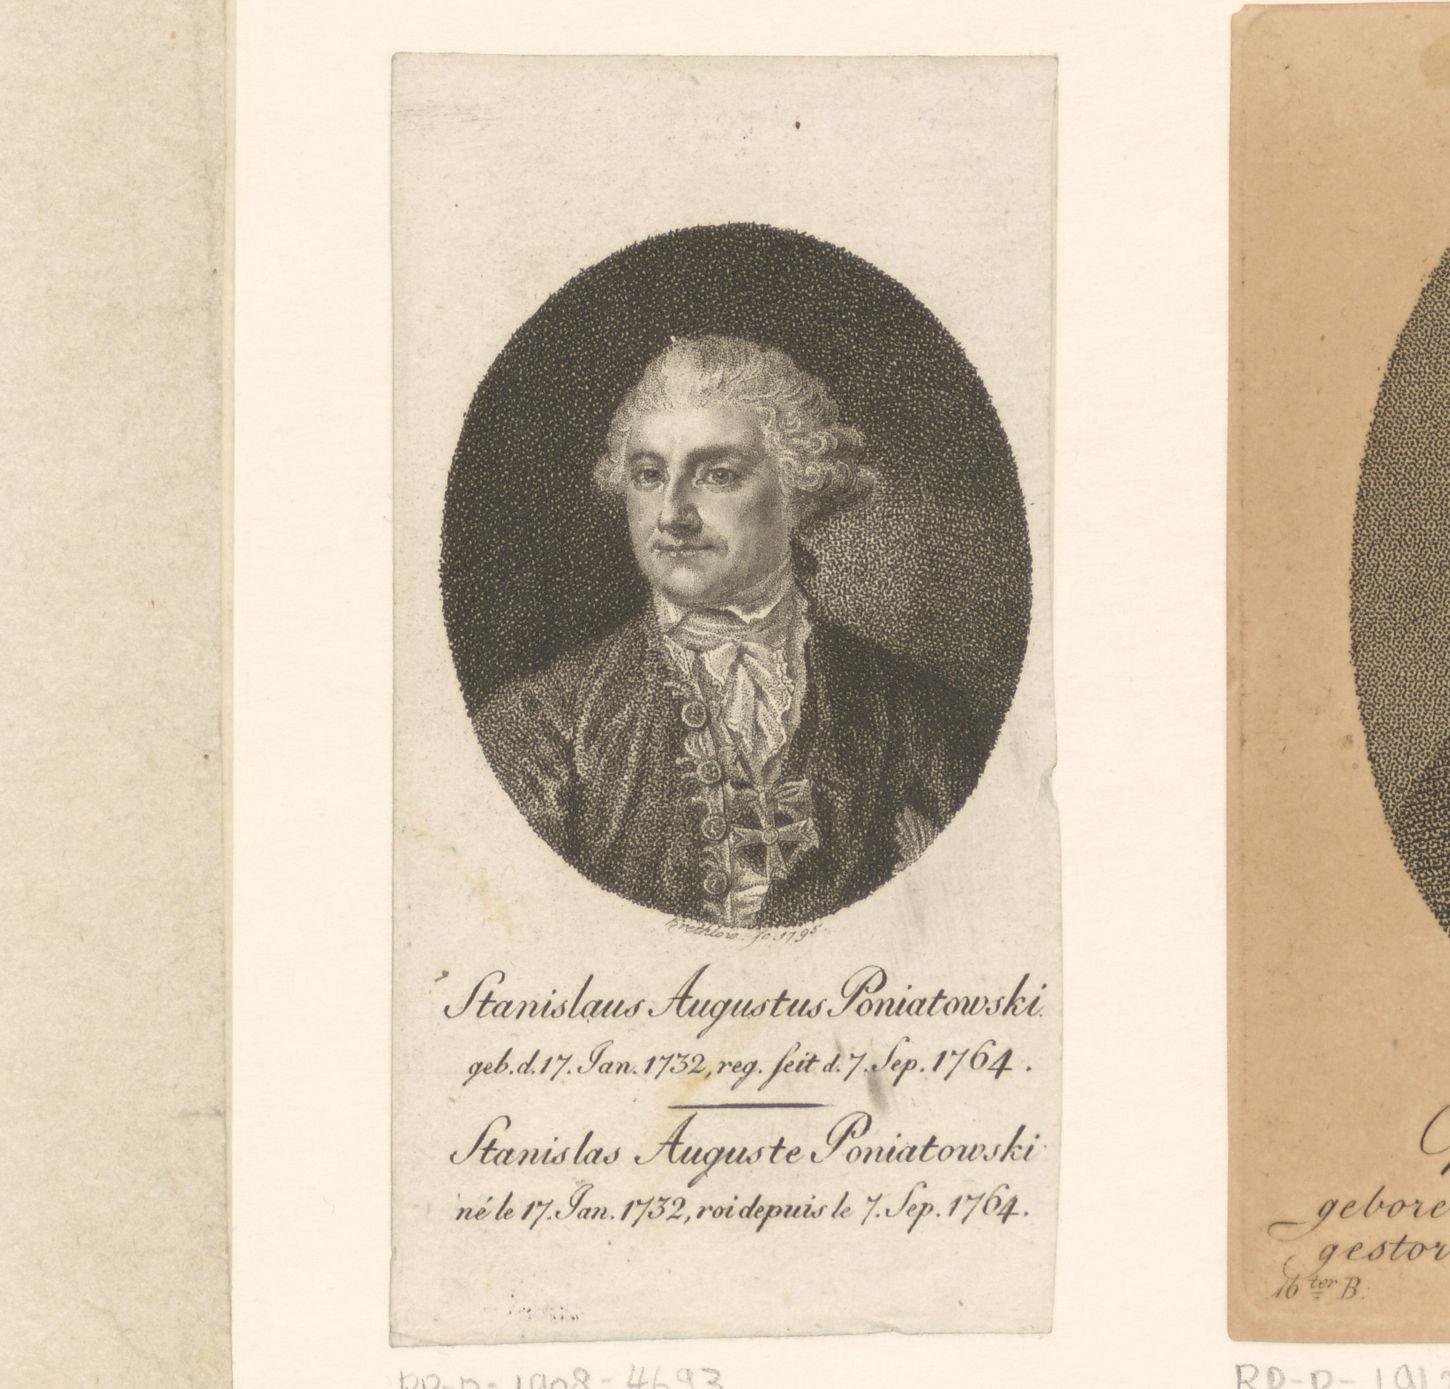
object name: print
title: Portret van Stanislaw August Poniatowski, koning van Polen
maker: johann ferdinand krethlow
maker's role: artist, draughtsman, print maker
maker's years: 1767-1842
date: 1795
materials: paper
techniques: stippling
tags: stanisław august poniatowski (koning van polen), historical persons, king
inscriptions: collector's mark: Lugt 2228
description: Tekst in het Duits en het Frans in de ondermarge.